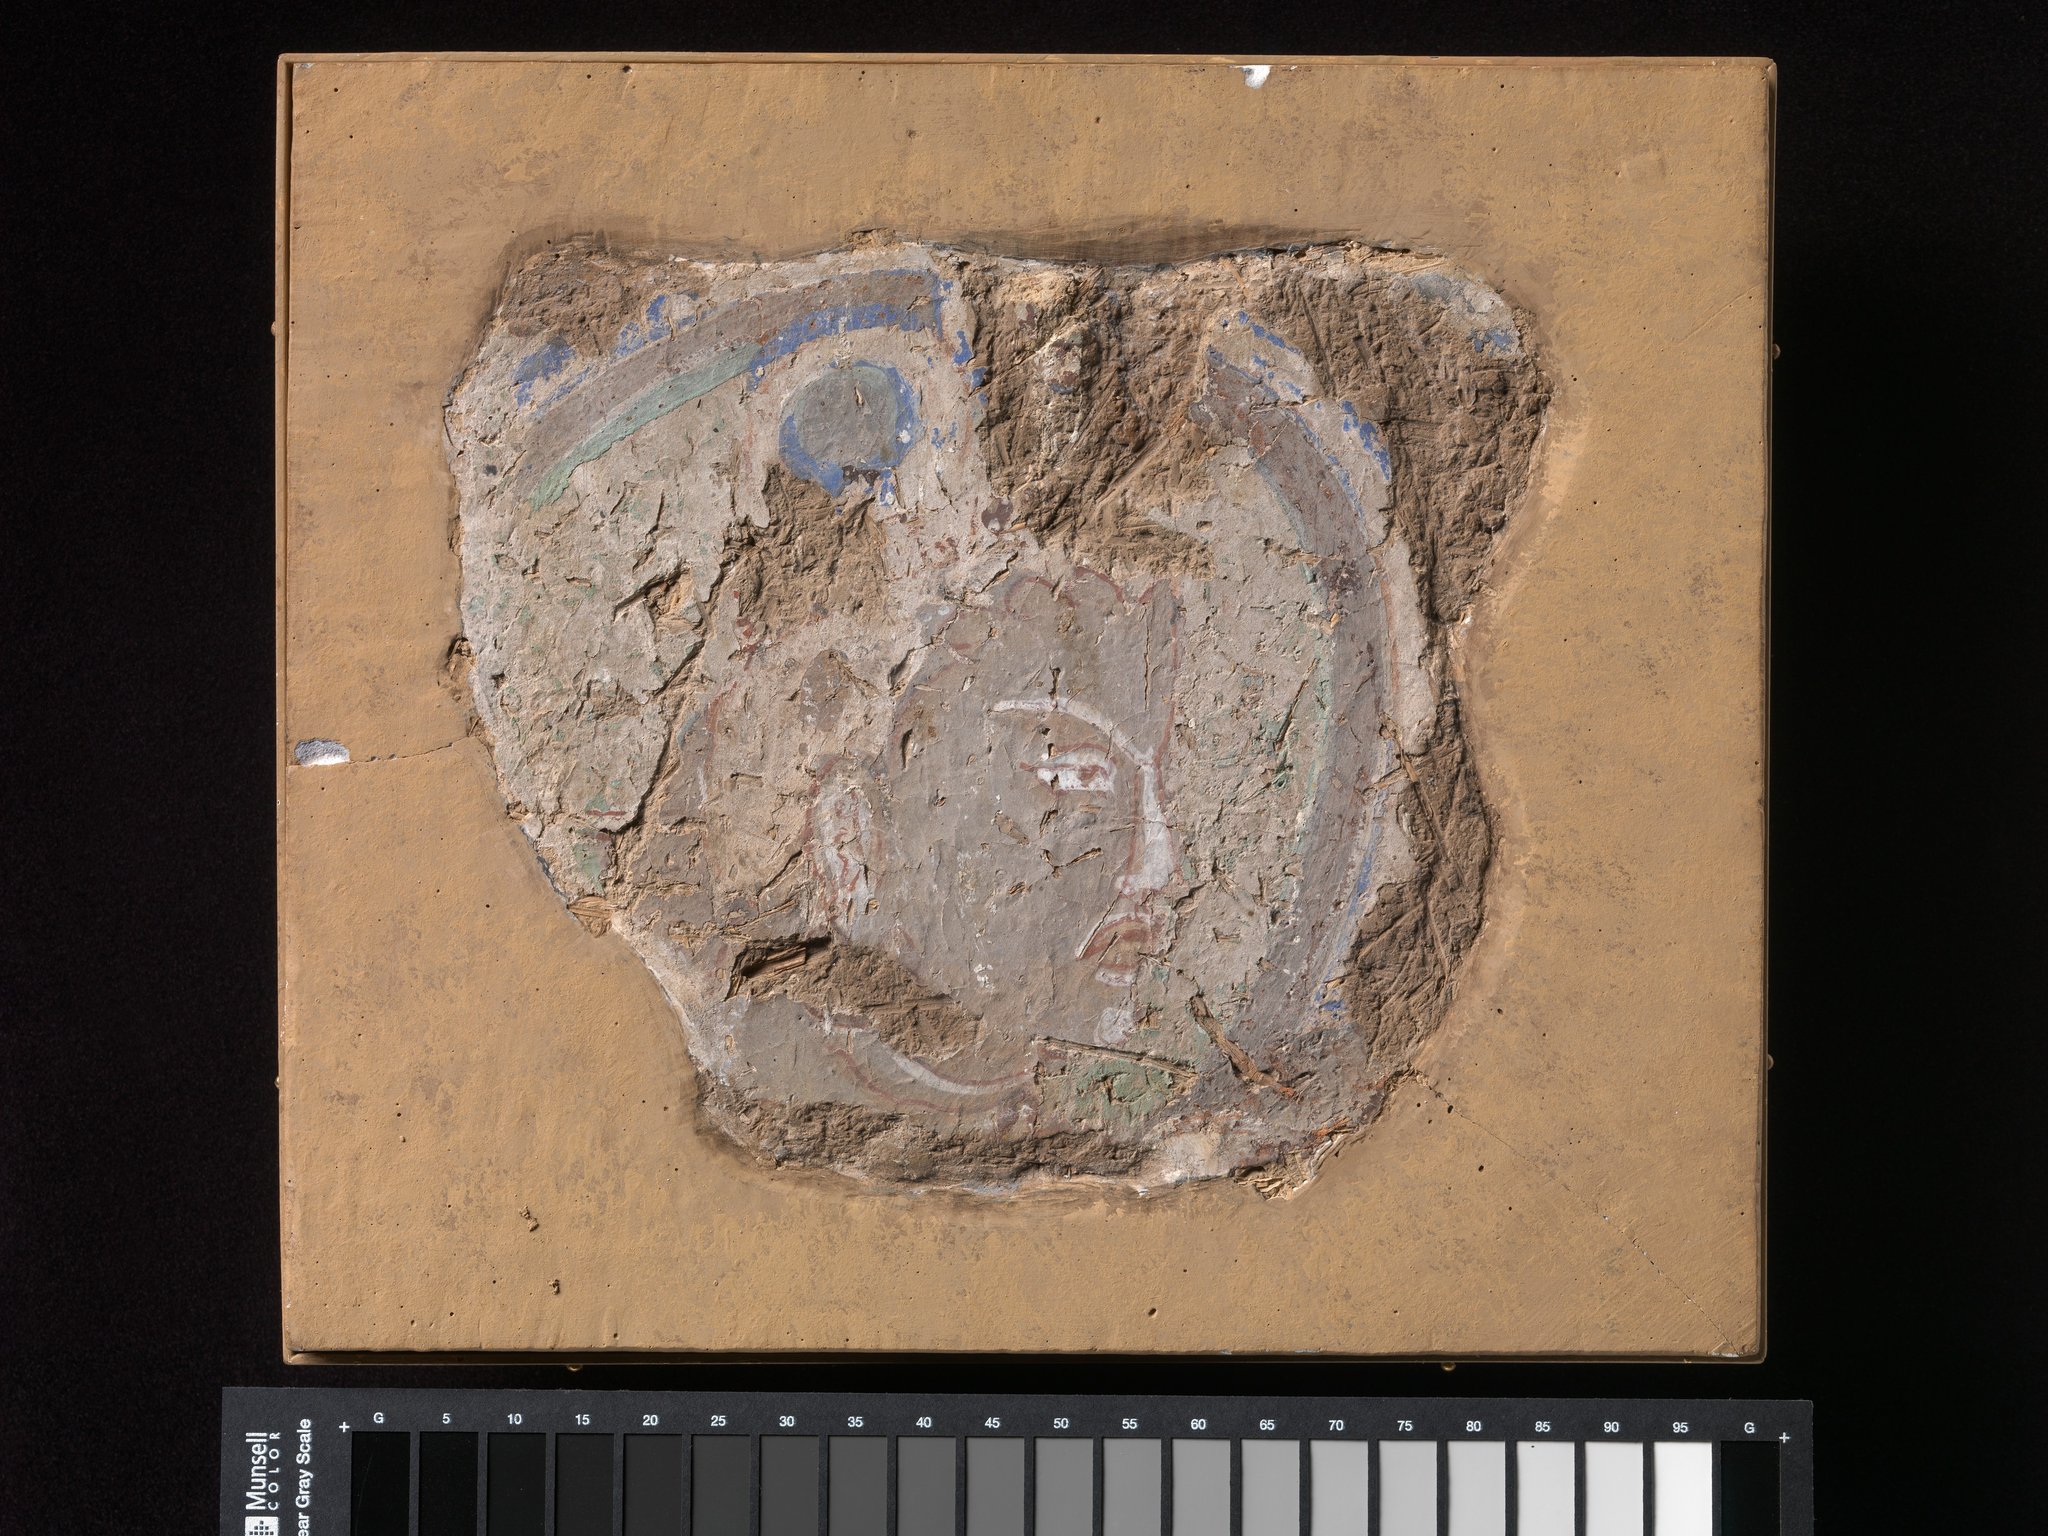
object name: wall painting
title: Head of a Buddhist Image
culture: chinese, xinjiang uyghur autonomous region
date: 501-700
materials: mud, pigment, plaster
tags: heads,buddhism